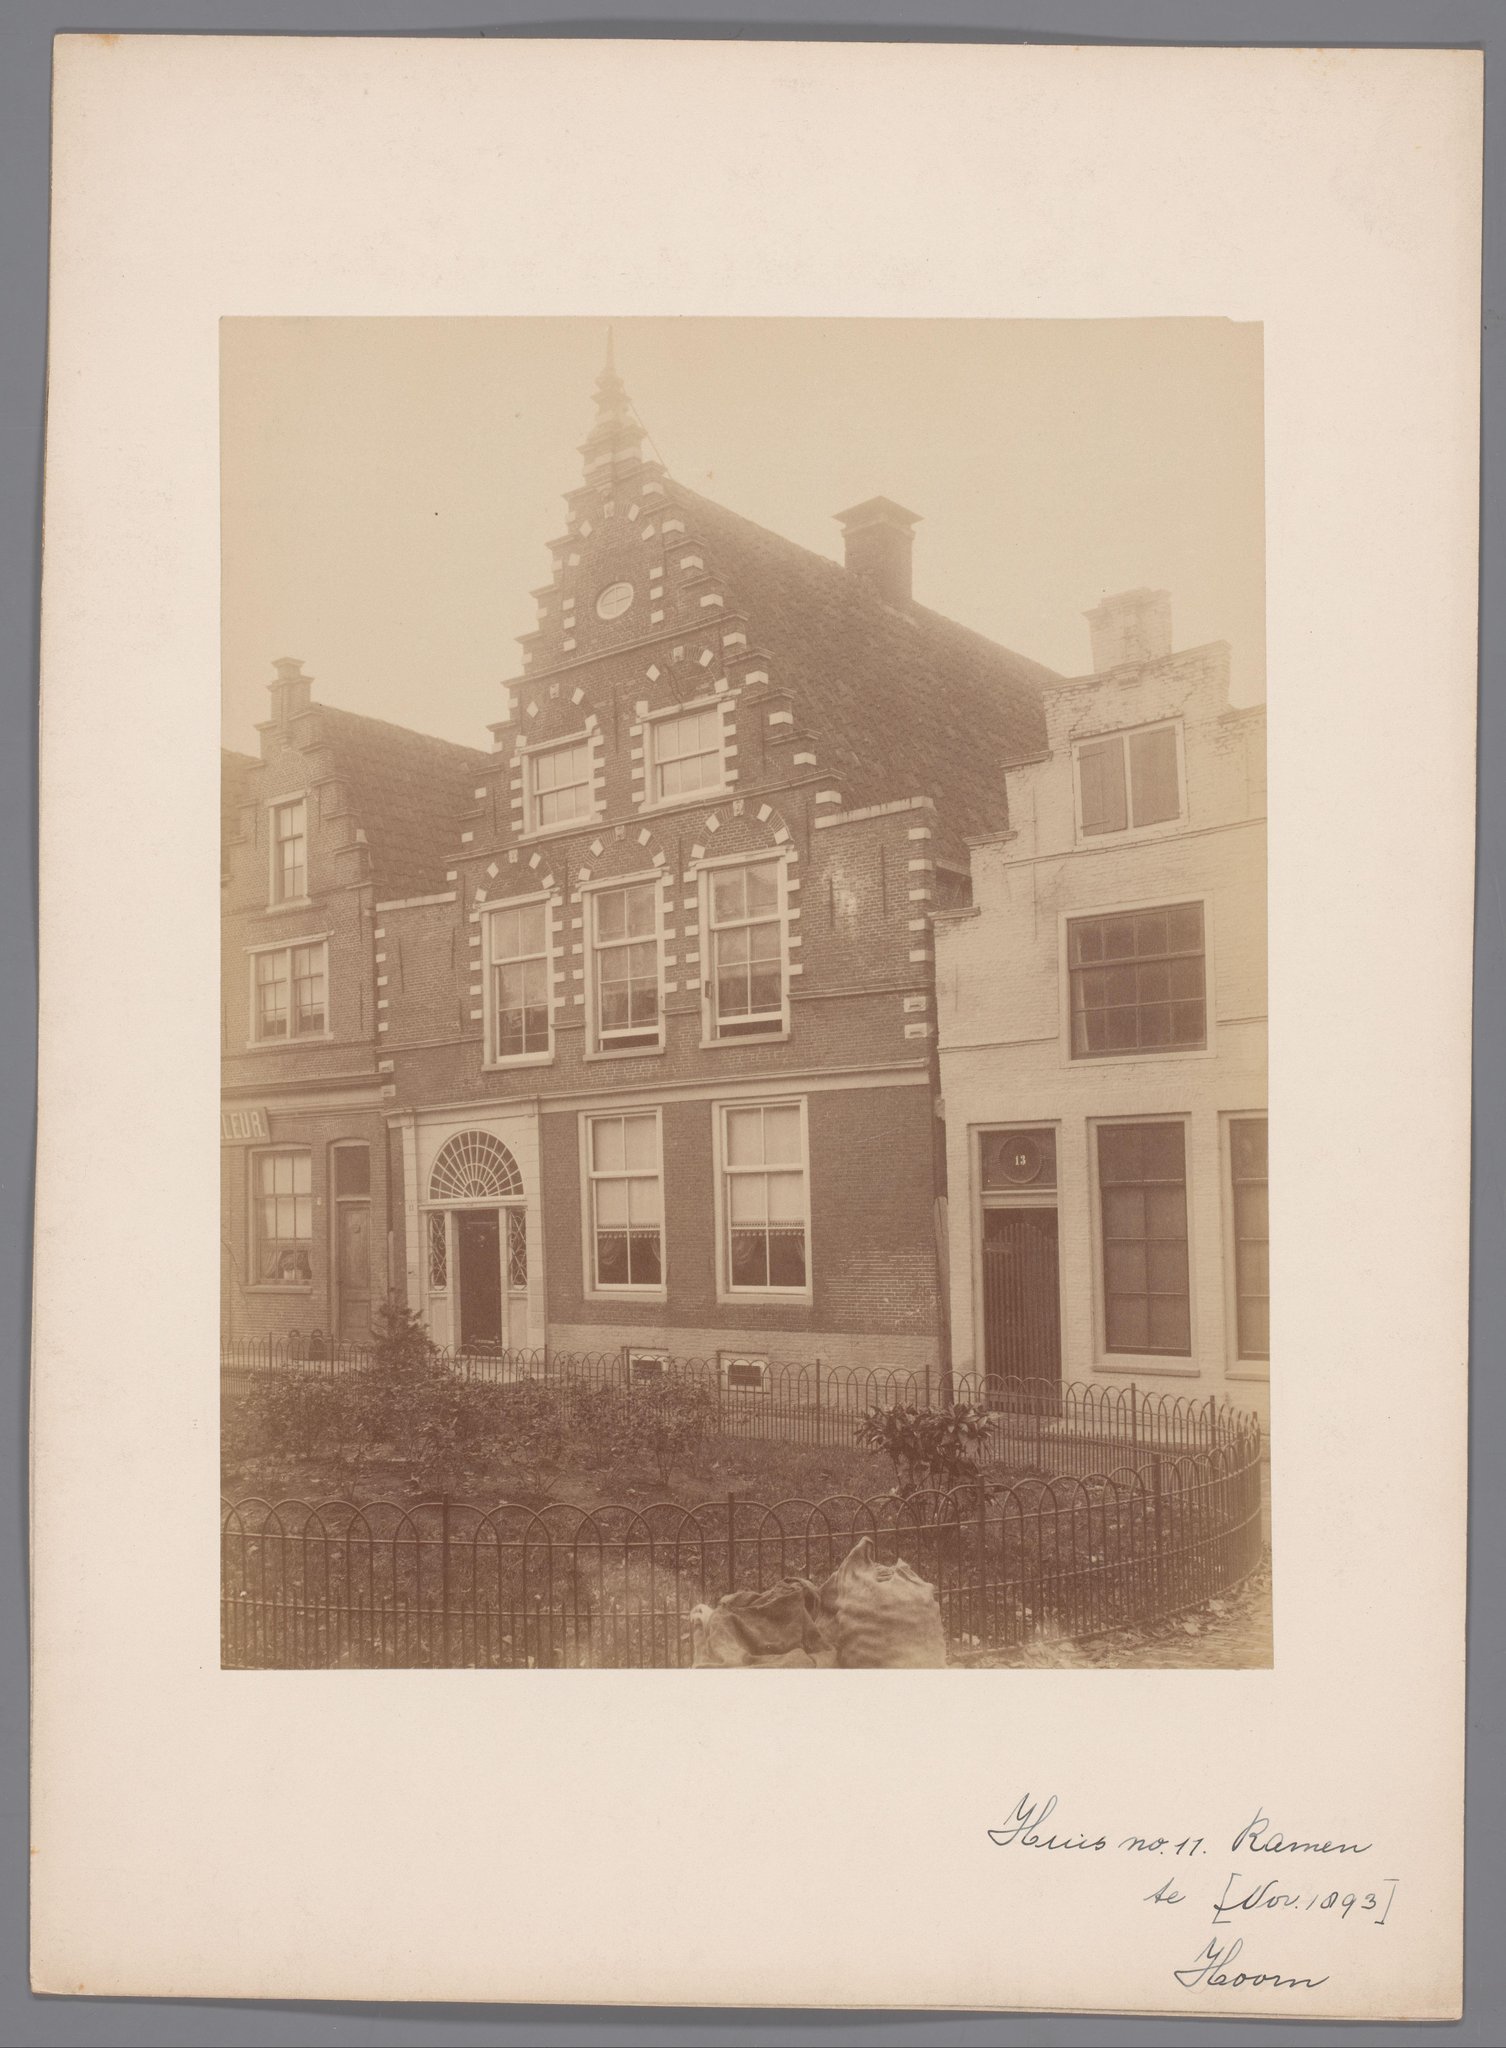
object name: photograph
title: Gezicht op Ramen 11 te Hoorn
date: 1893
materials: cardboard, photographic support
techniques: albumen print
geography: hoorn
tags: urban housing, façade (of house or building)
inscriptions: annotation: ‘Huis no. 11 Ramen/ te [Nov. 1893] Hoorn’, annotation: ‘Huis N:11/ Ramen te Hoorn (N.H.)/ Nov. 1893’